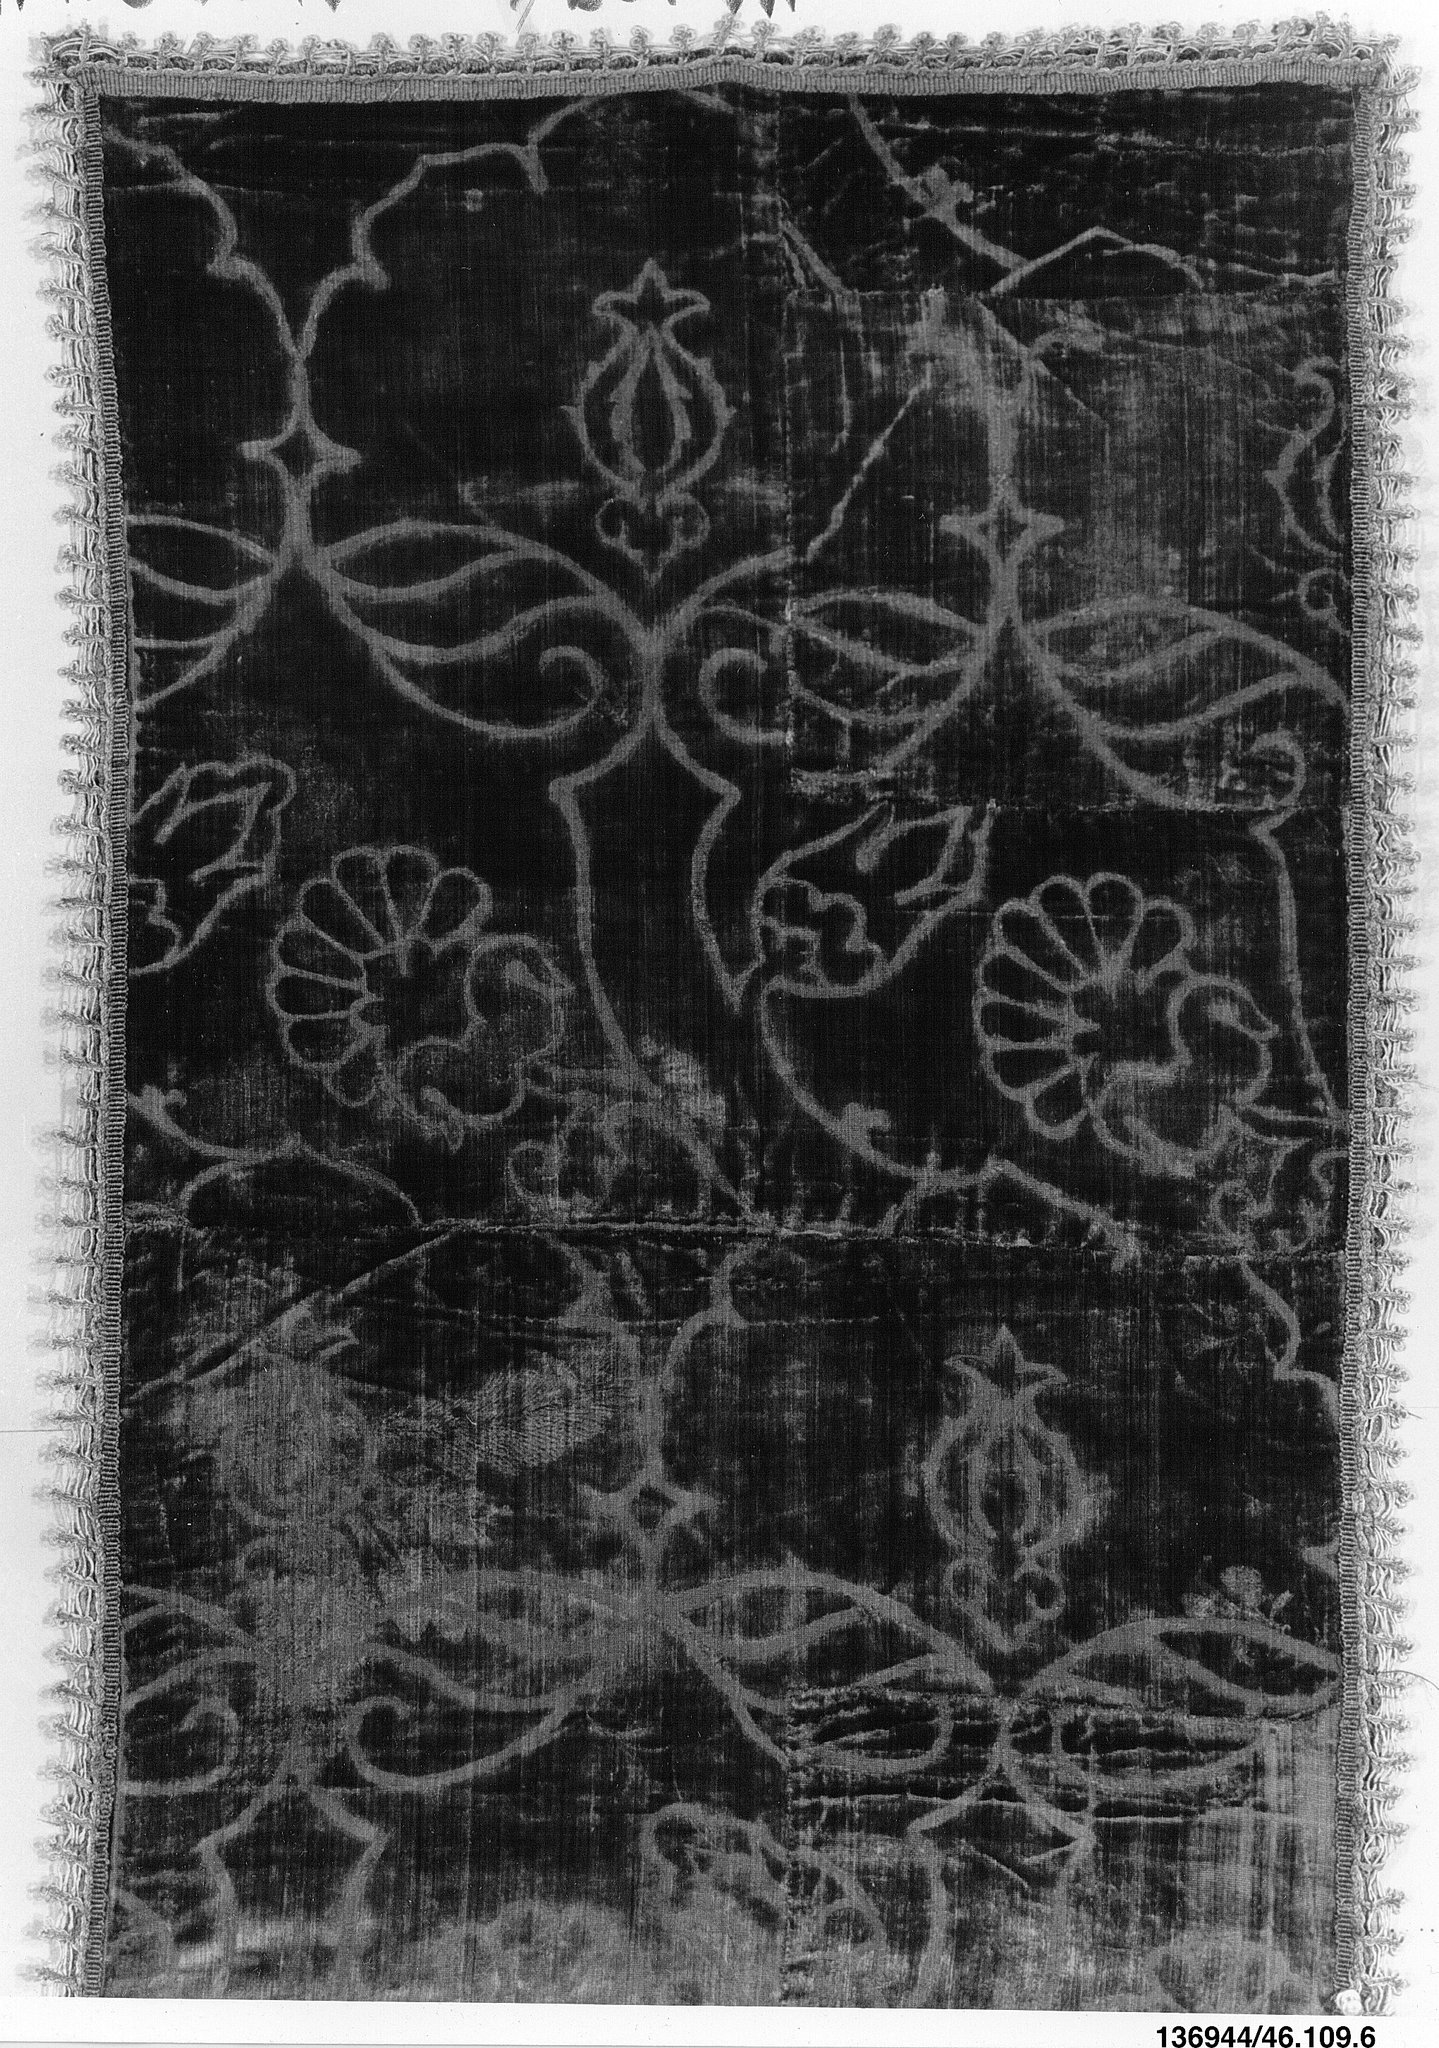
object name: piece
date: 1401-1500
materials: silk